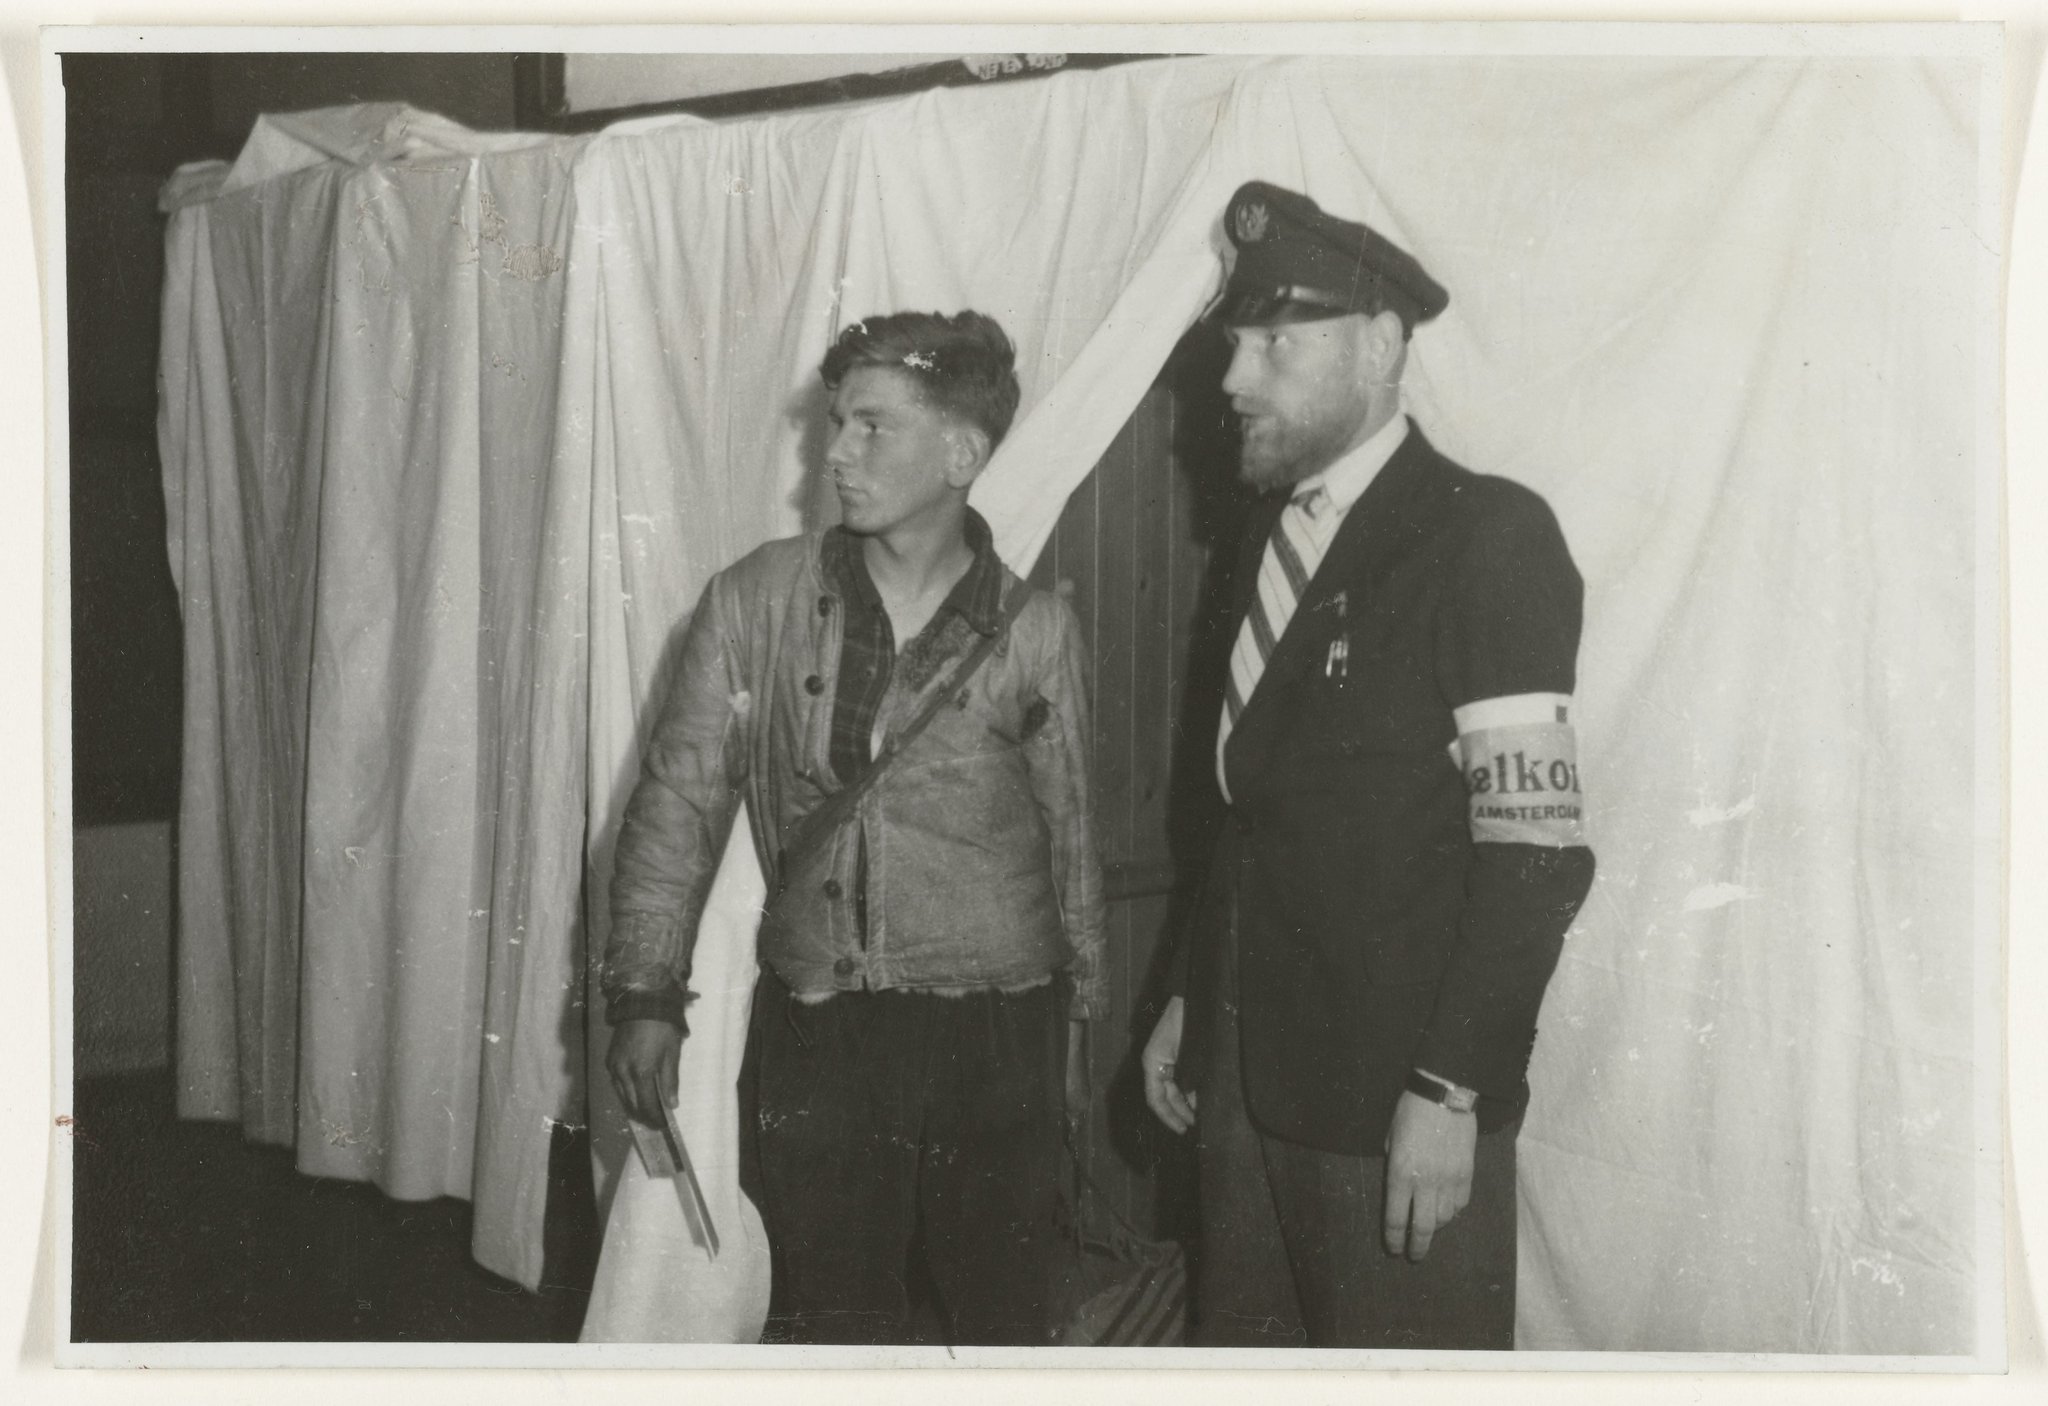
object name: photograph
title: Medisch onderzoek gerepatrieerden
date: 1945-1946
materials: photographic support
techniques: photography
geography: amsterdam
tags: amsterdam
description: Medisch onderzoek van een ex-gevangene uit een concentratiekamp na zijn terugkeer in Nederland. Hij komt uit een geimproviseerd kamertje, naast hem een man met een mouwband met: Welkom in Amsterdam.